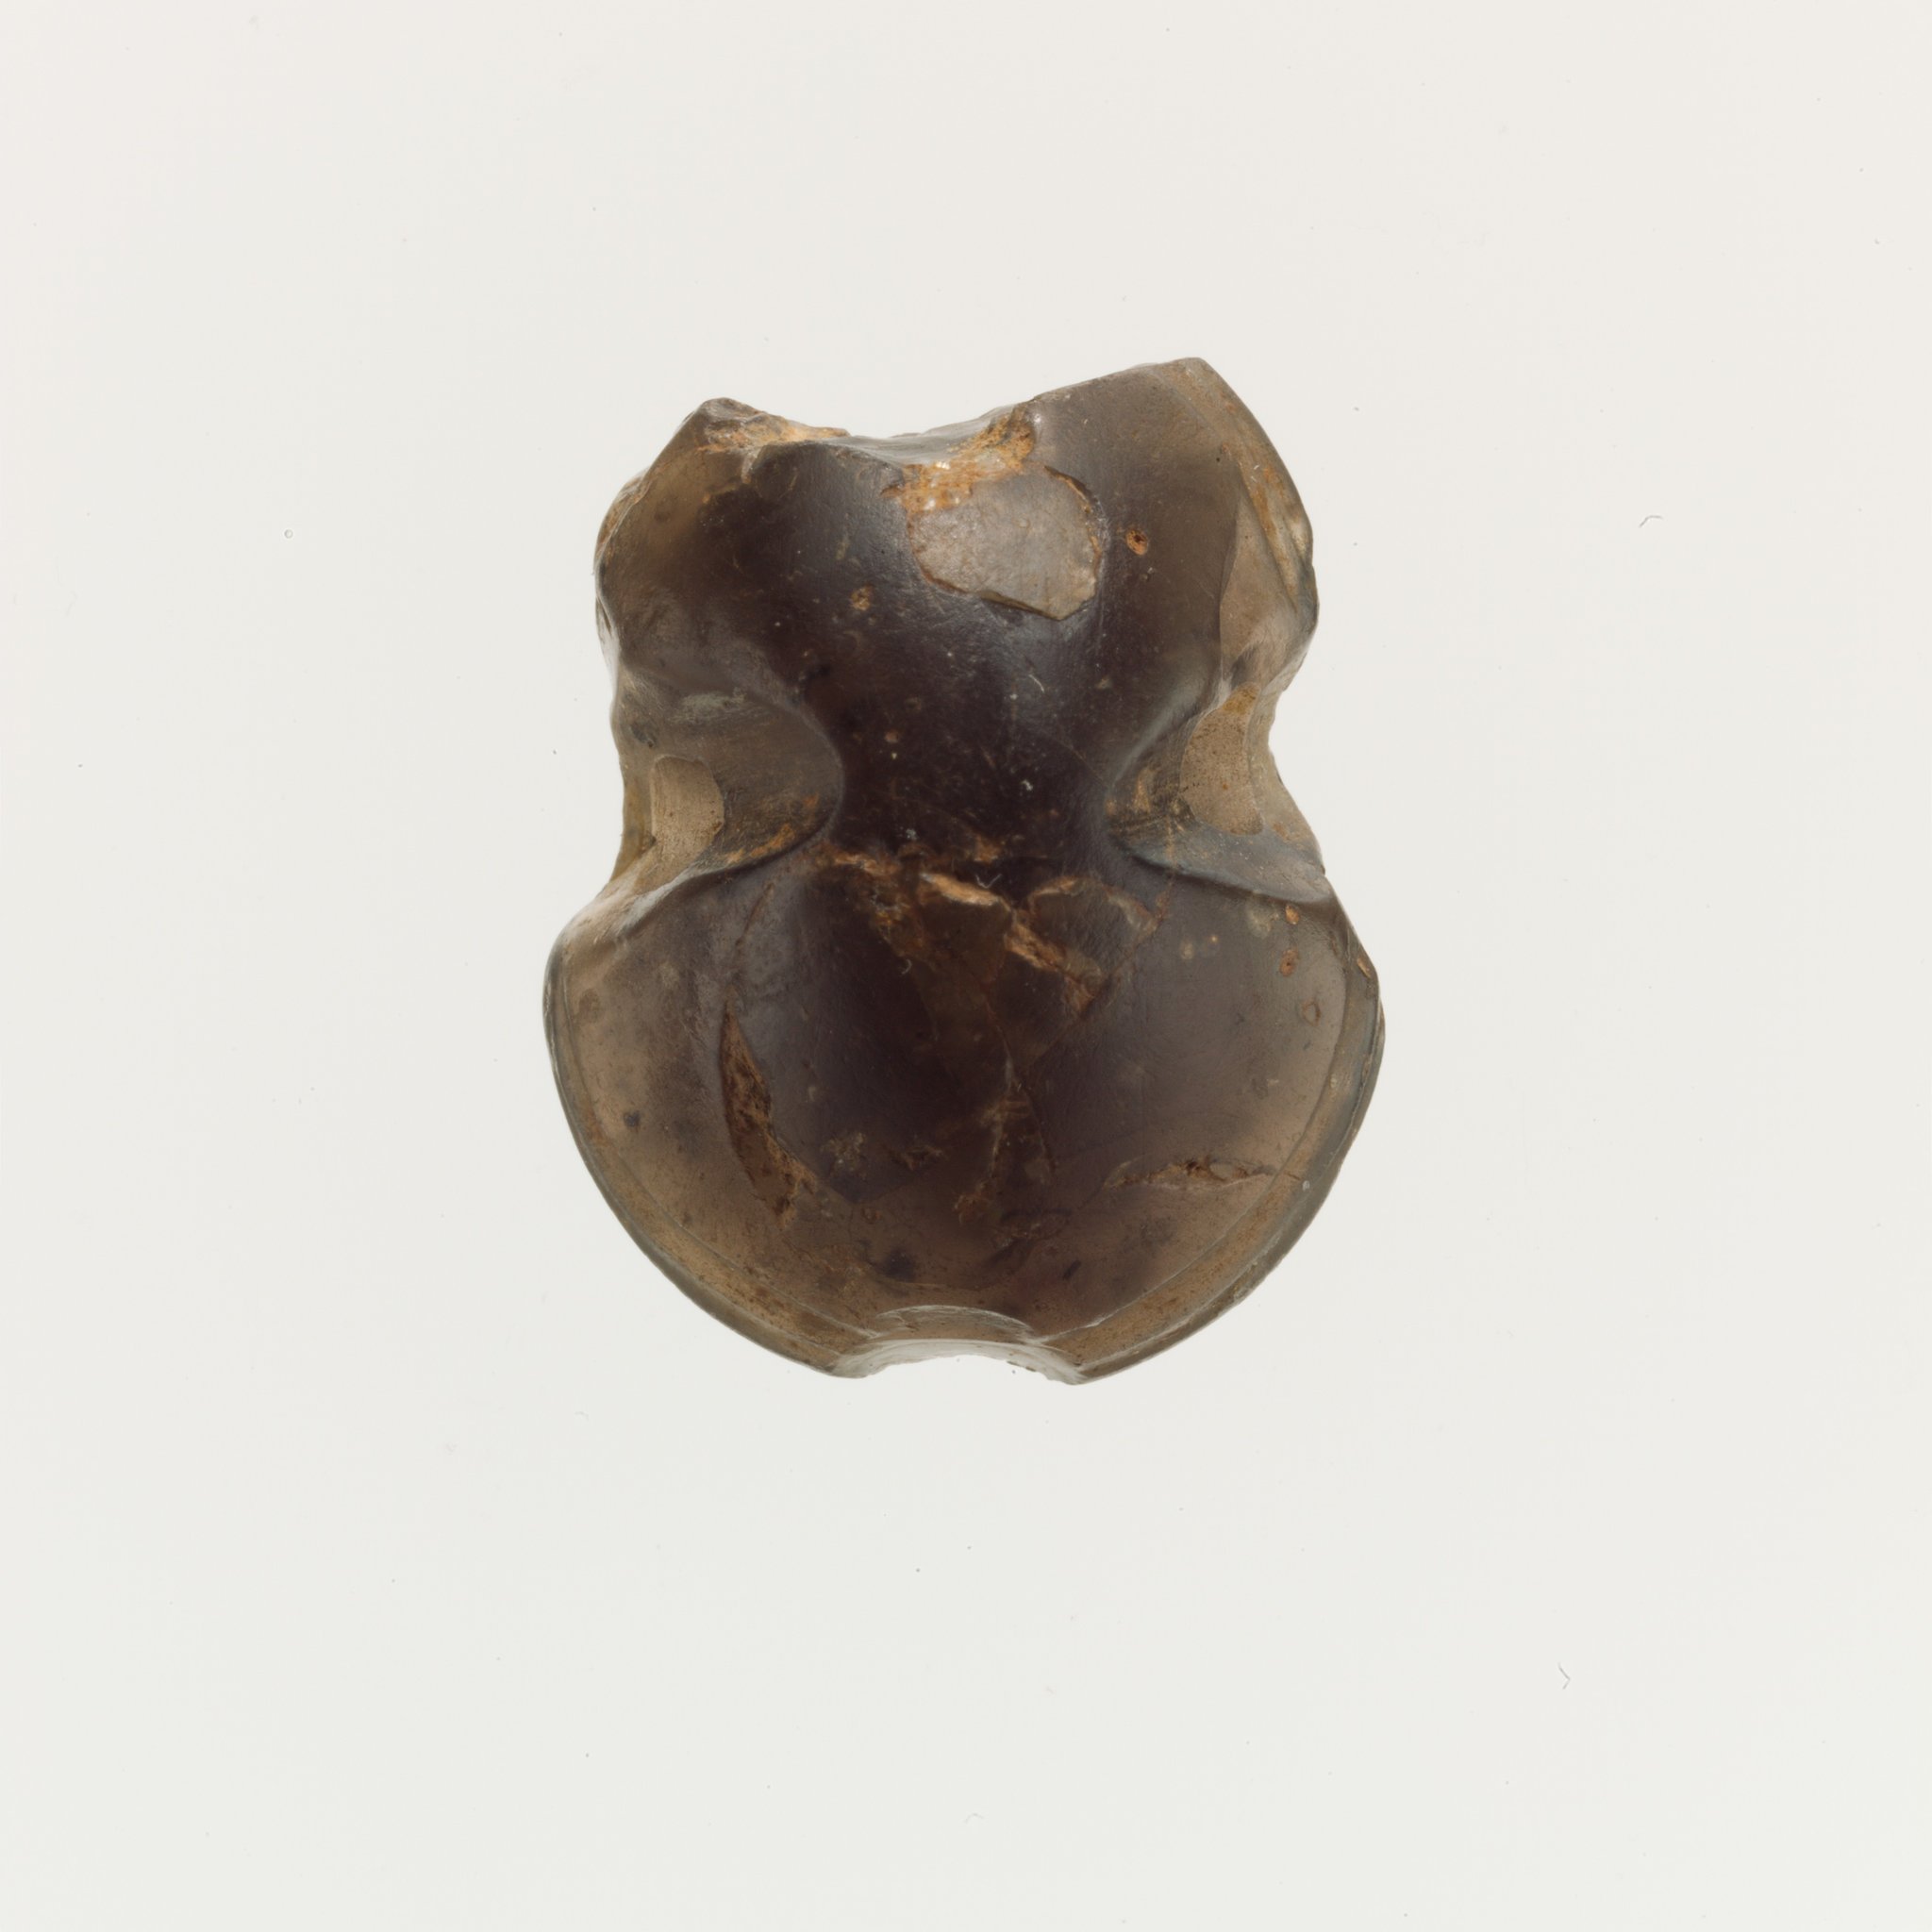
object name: spindle whorl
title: Obsidian bead in the form of of a figure-of-eight shield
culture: minoan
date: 2200-1450 BCE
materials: obsidian